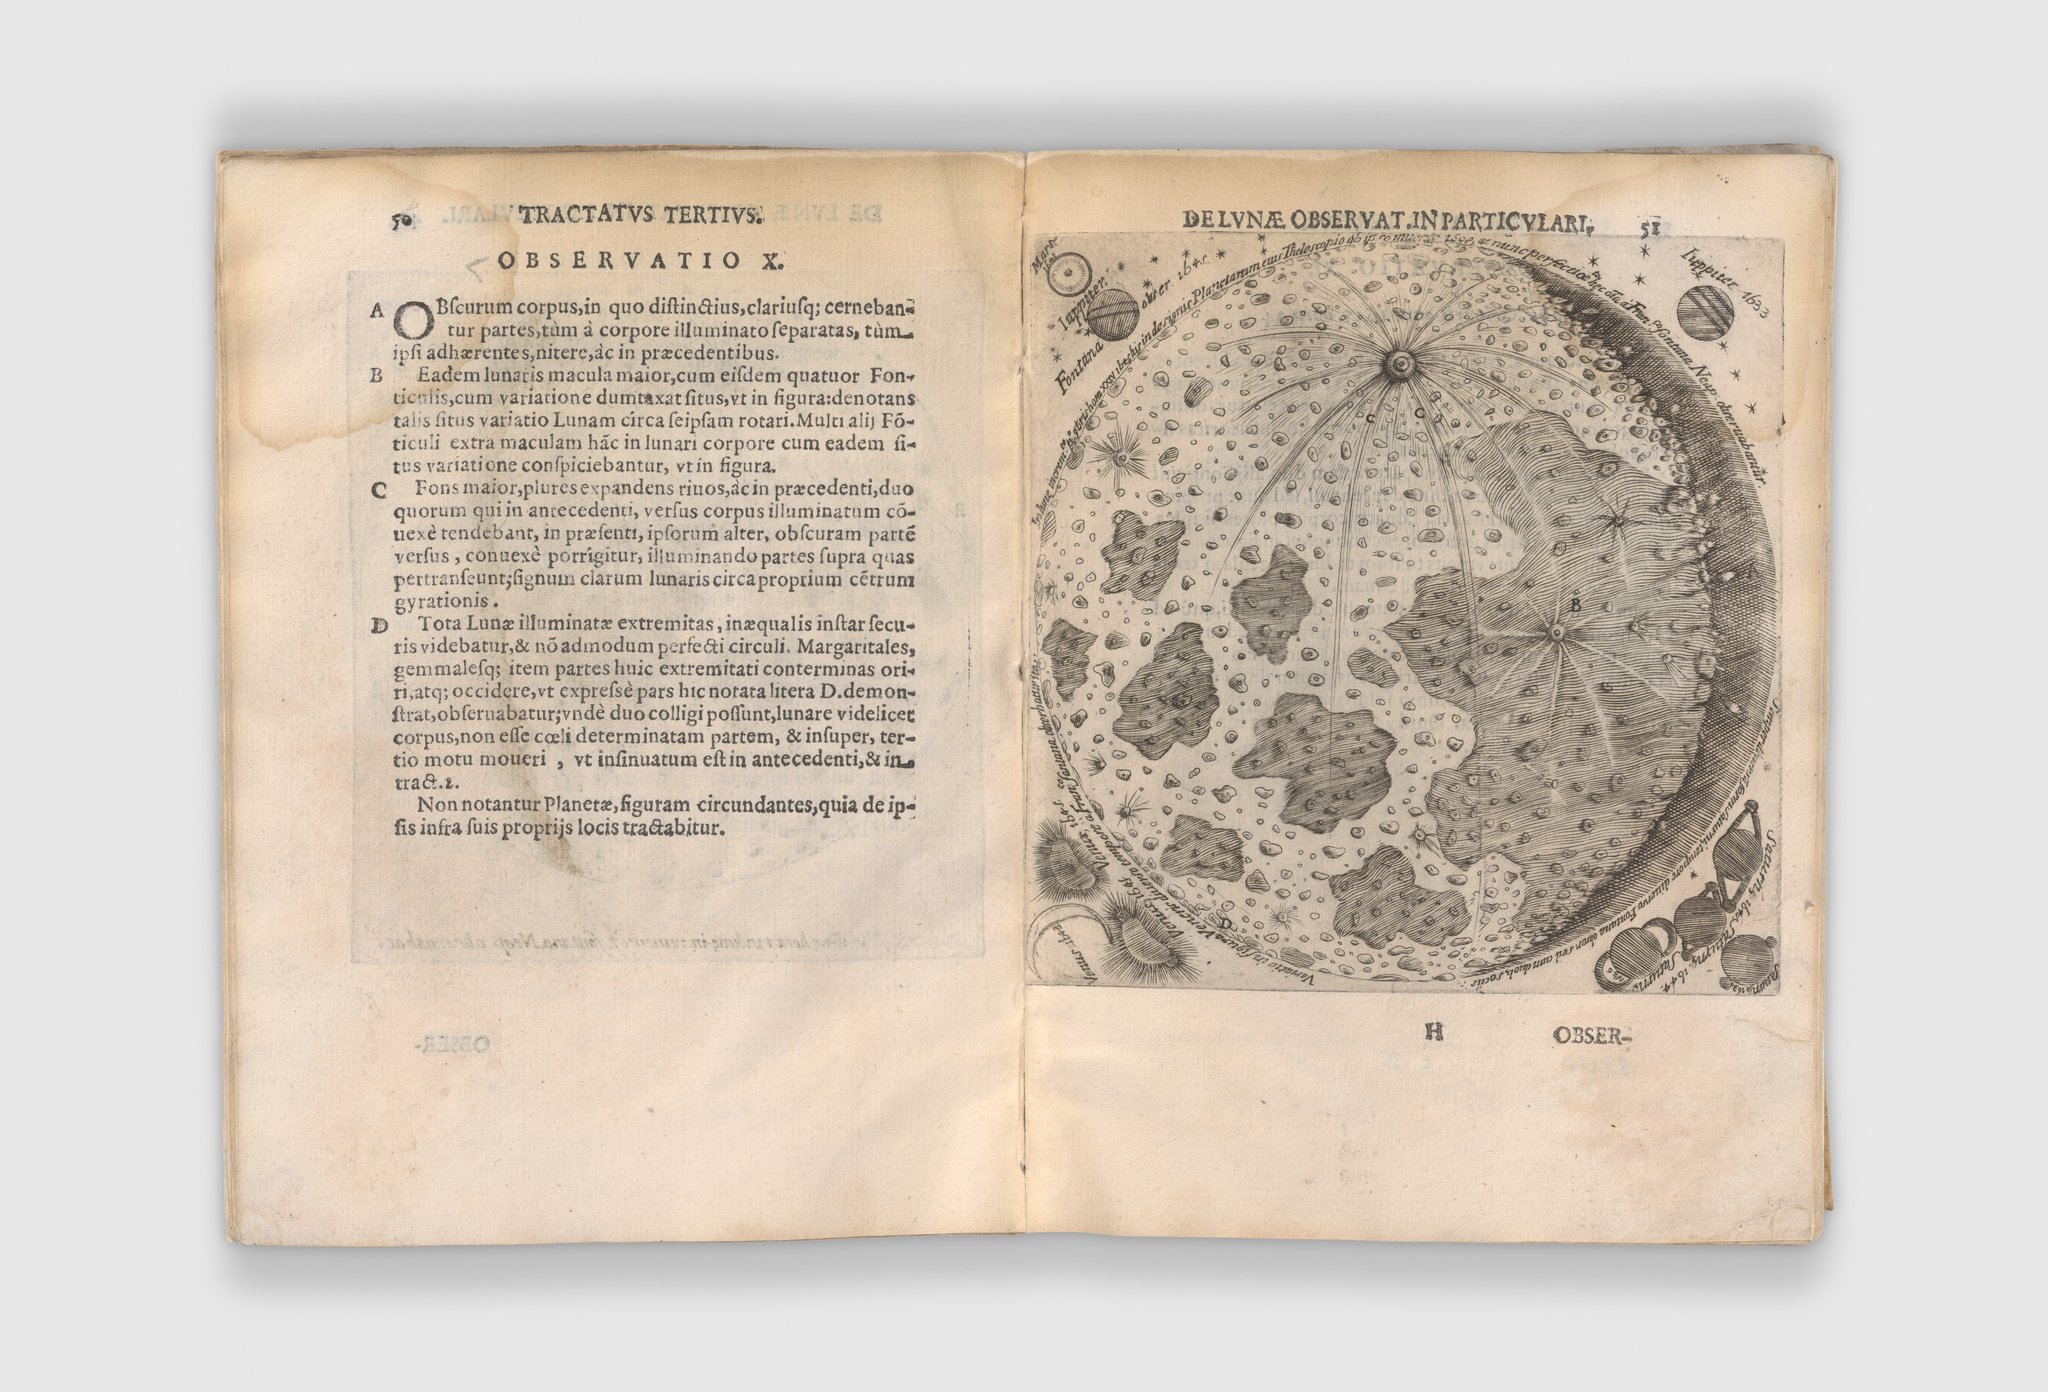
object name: book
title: Novae coelestium, terrestriumque rerum observationes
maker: francisco fontana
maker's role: artist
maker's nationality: italian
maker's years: 1580-1656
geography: italy